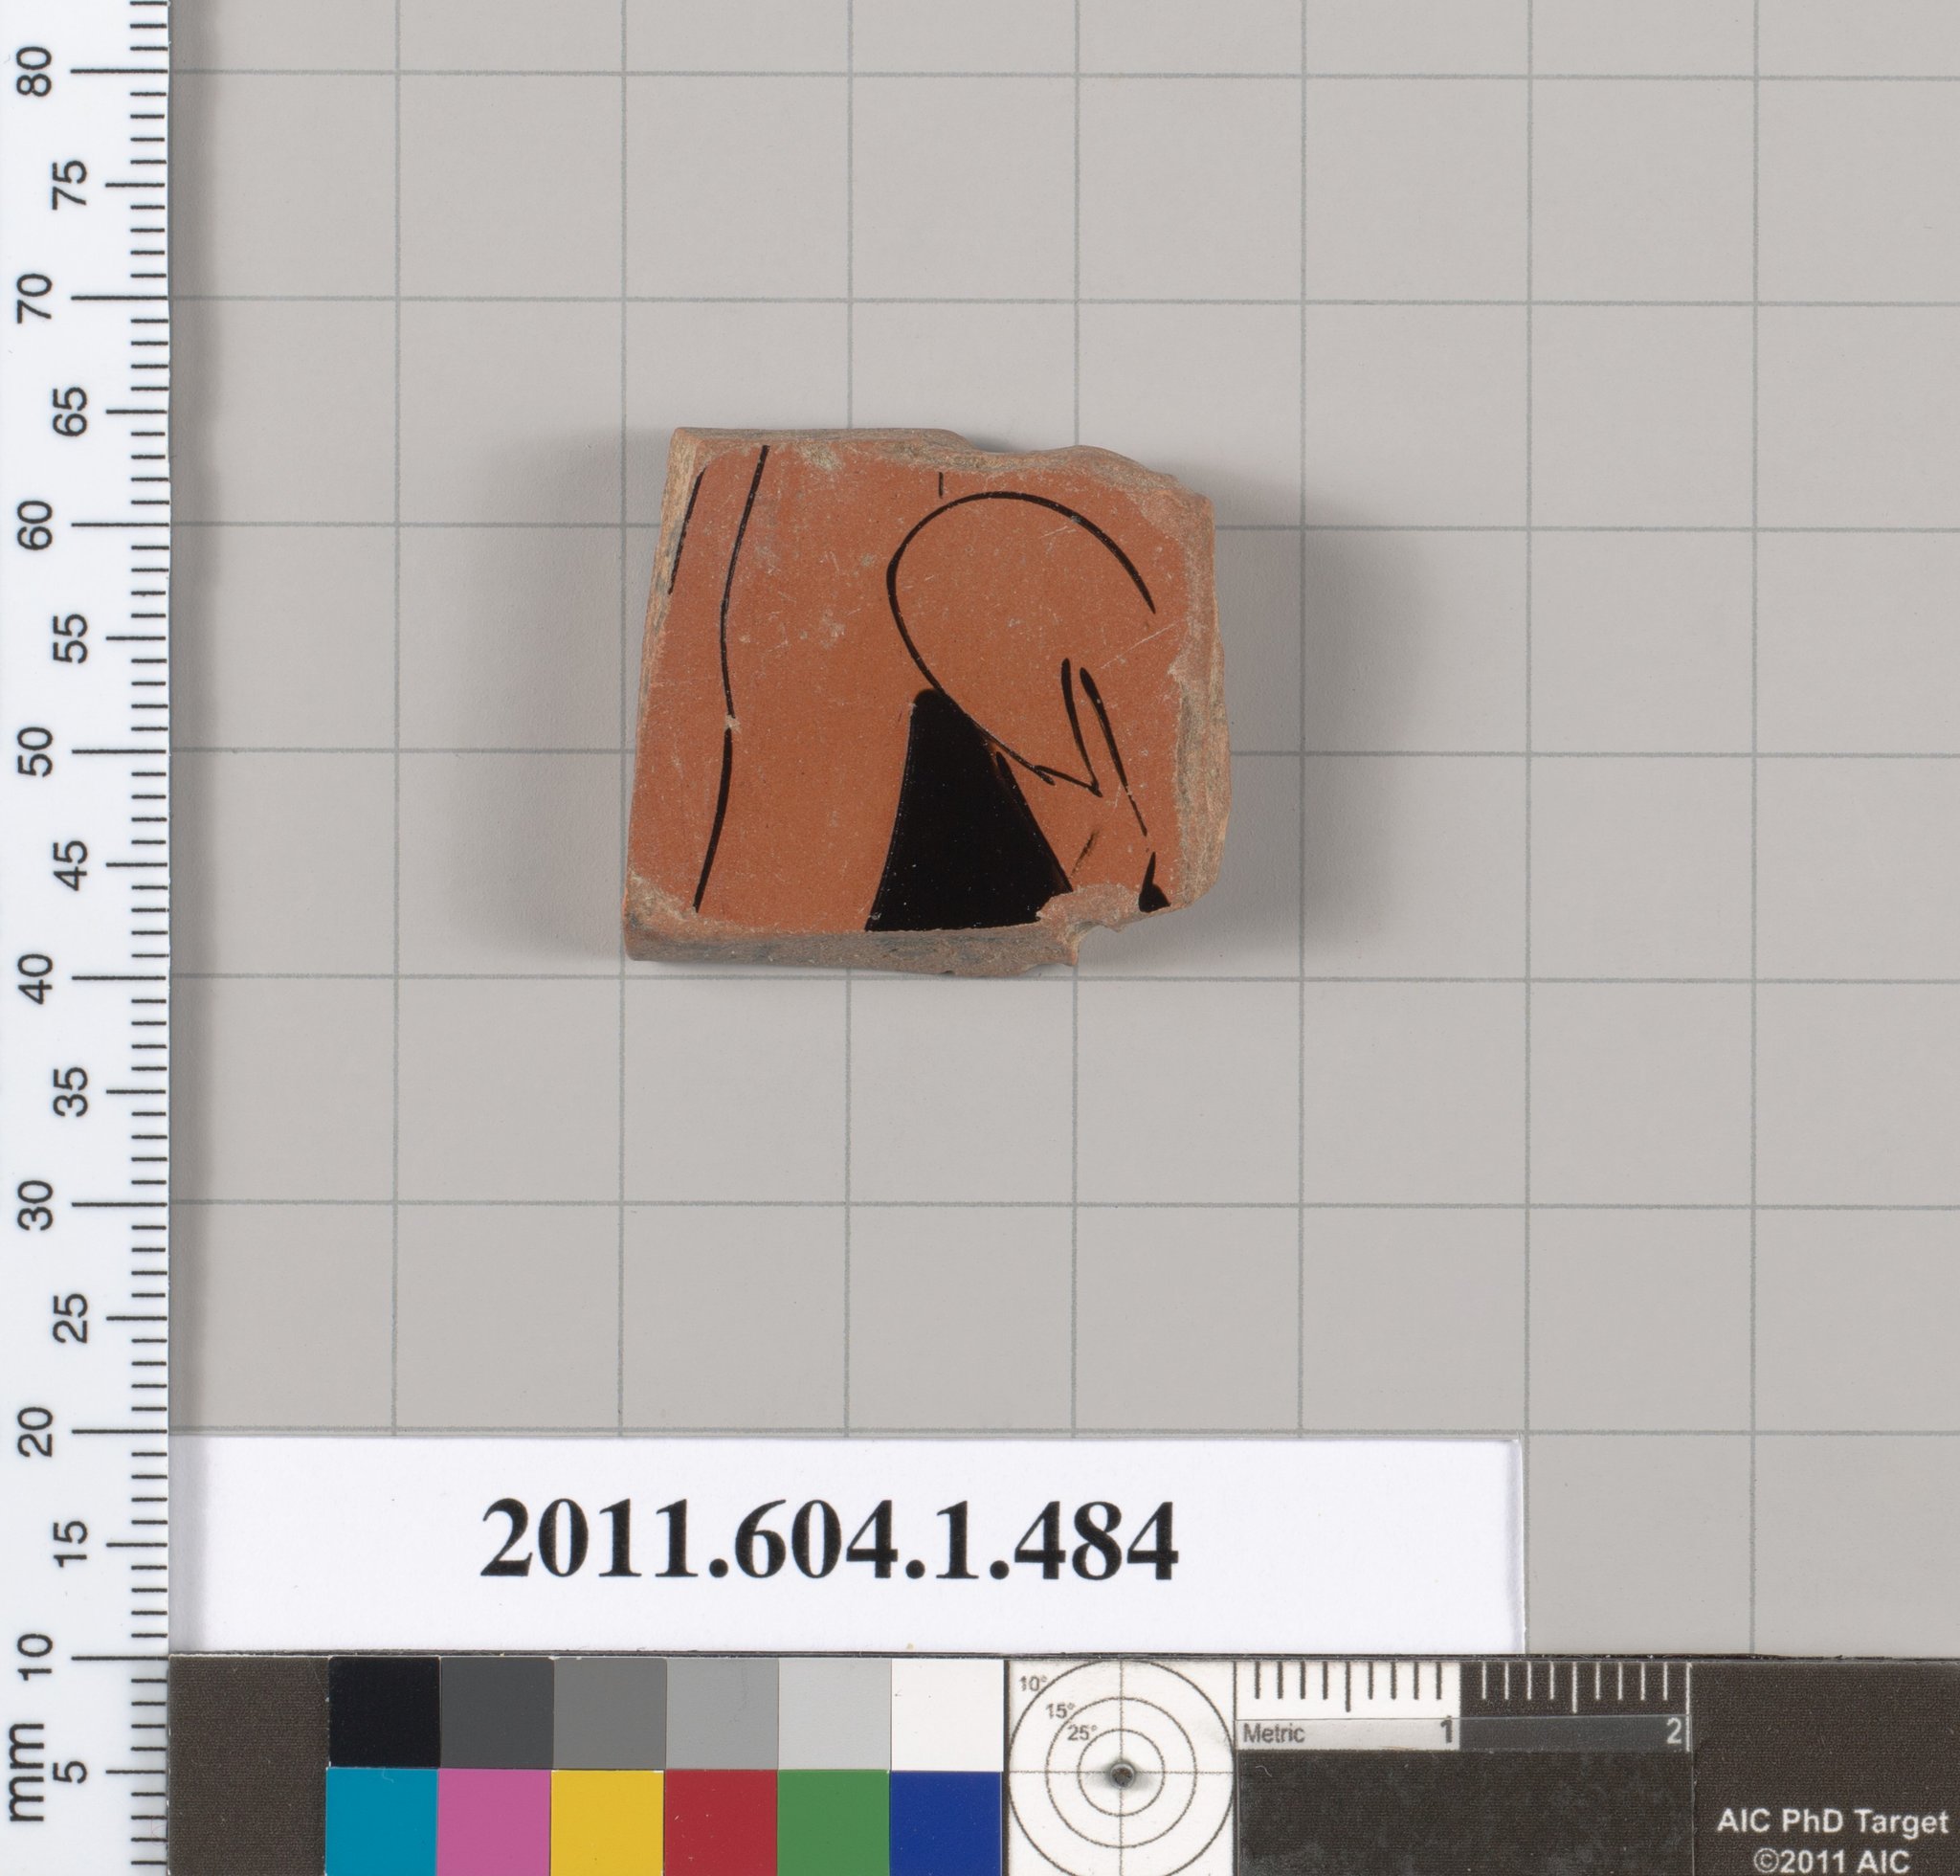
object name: kylix fragment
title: Terracotta fragment of a kylix (drinking cup)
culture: greek, attic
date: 490-480 BCE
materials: terracotta